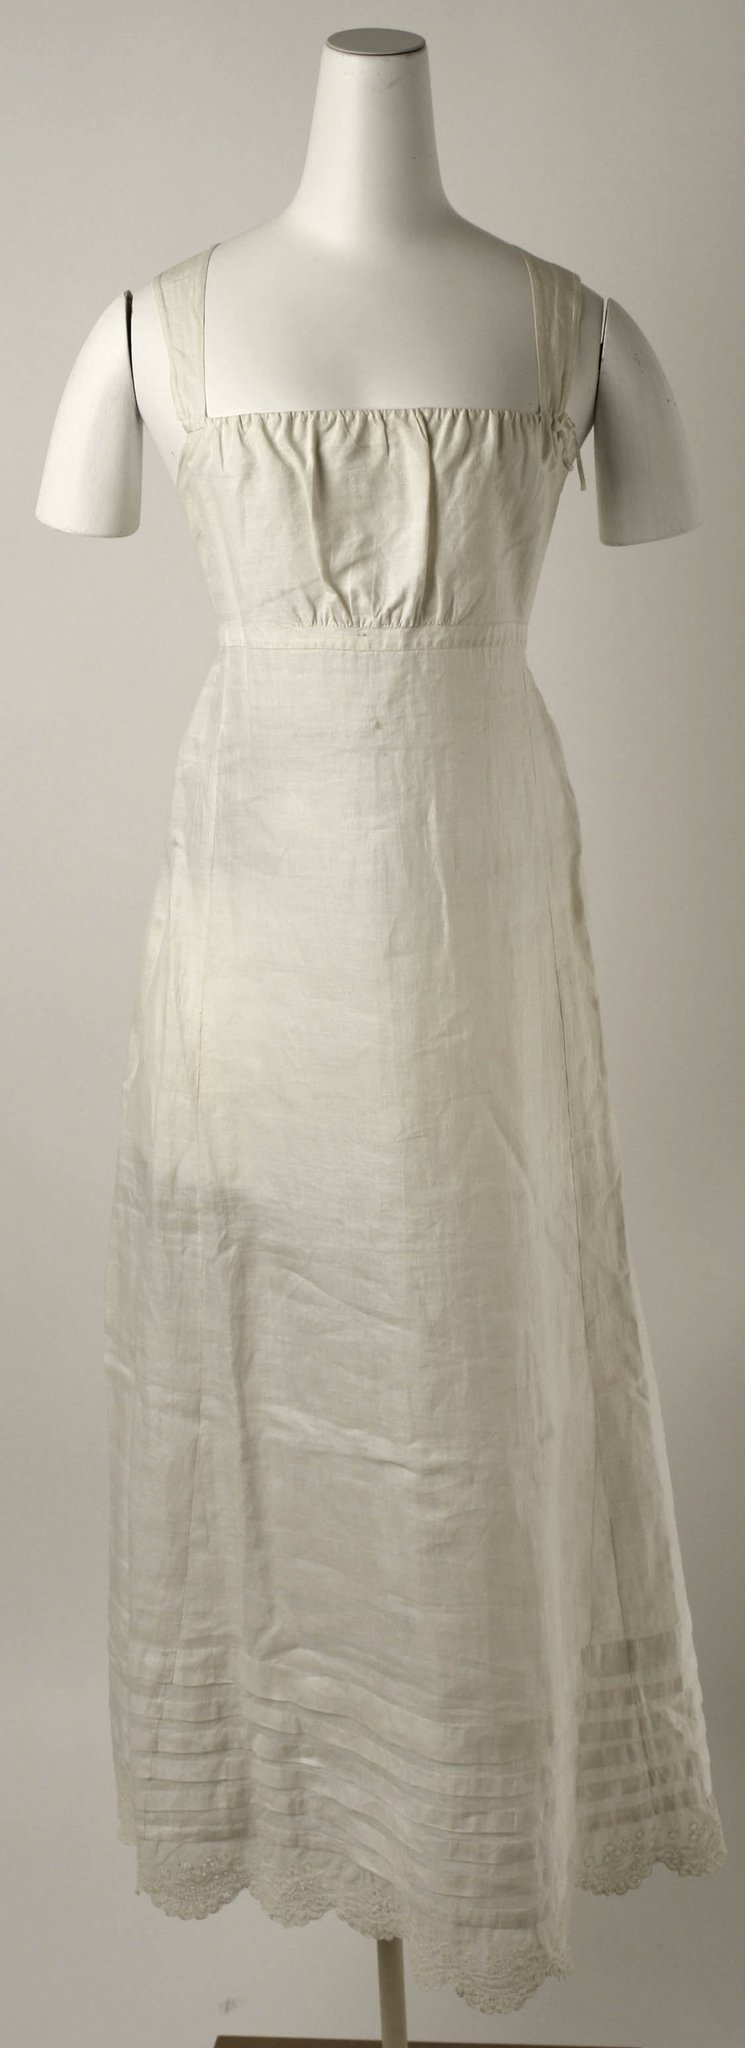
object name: petticoat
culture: american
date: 1801-1833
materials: linen